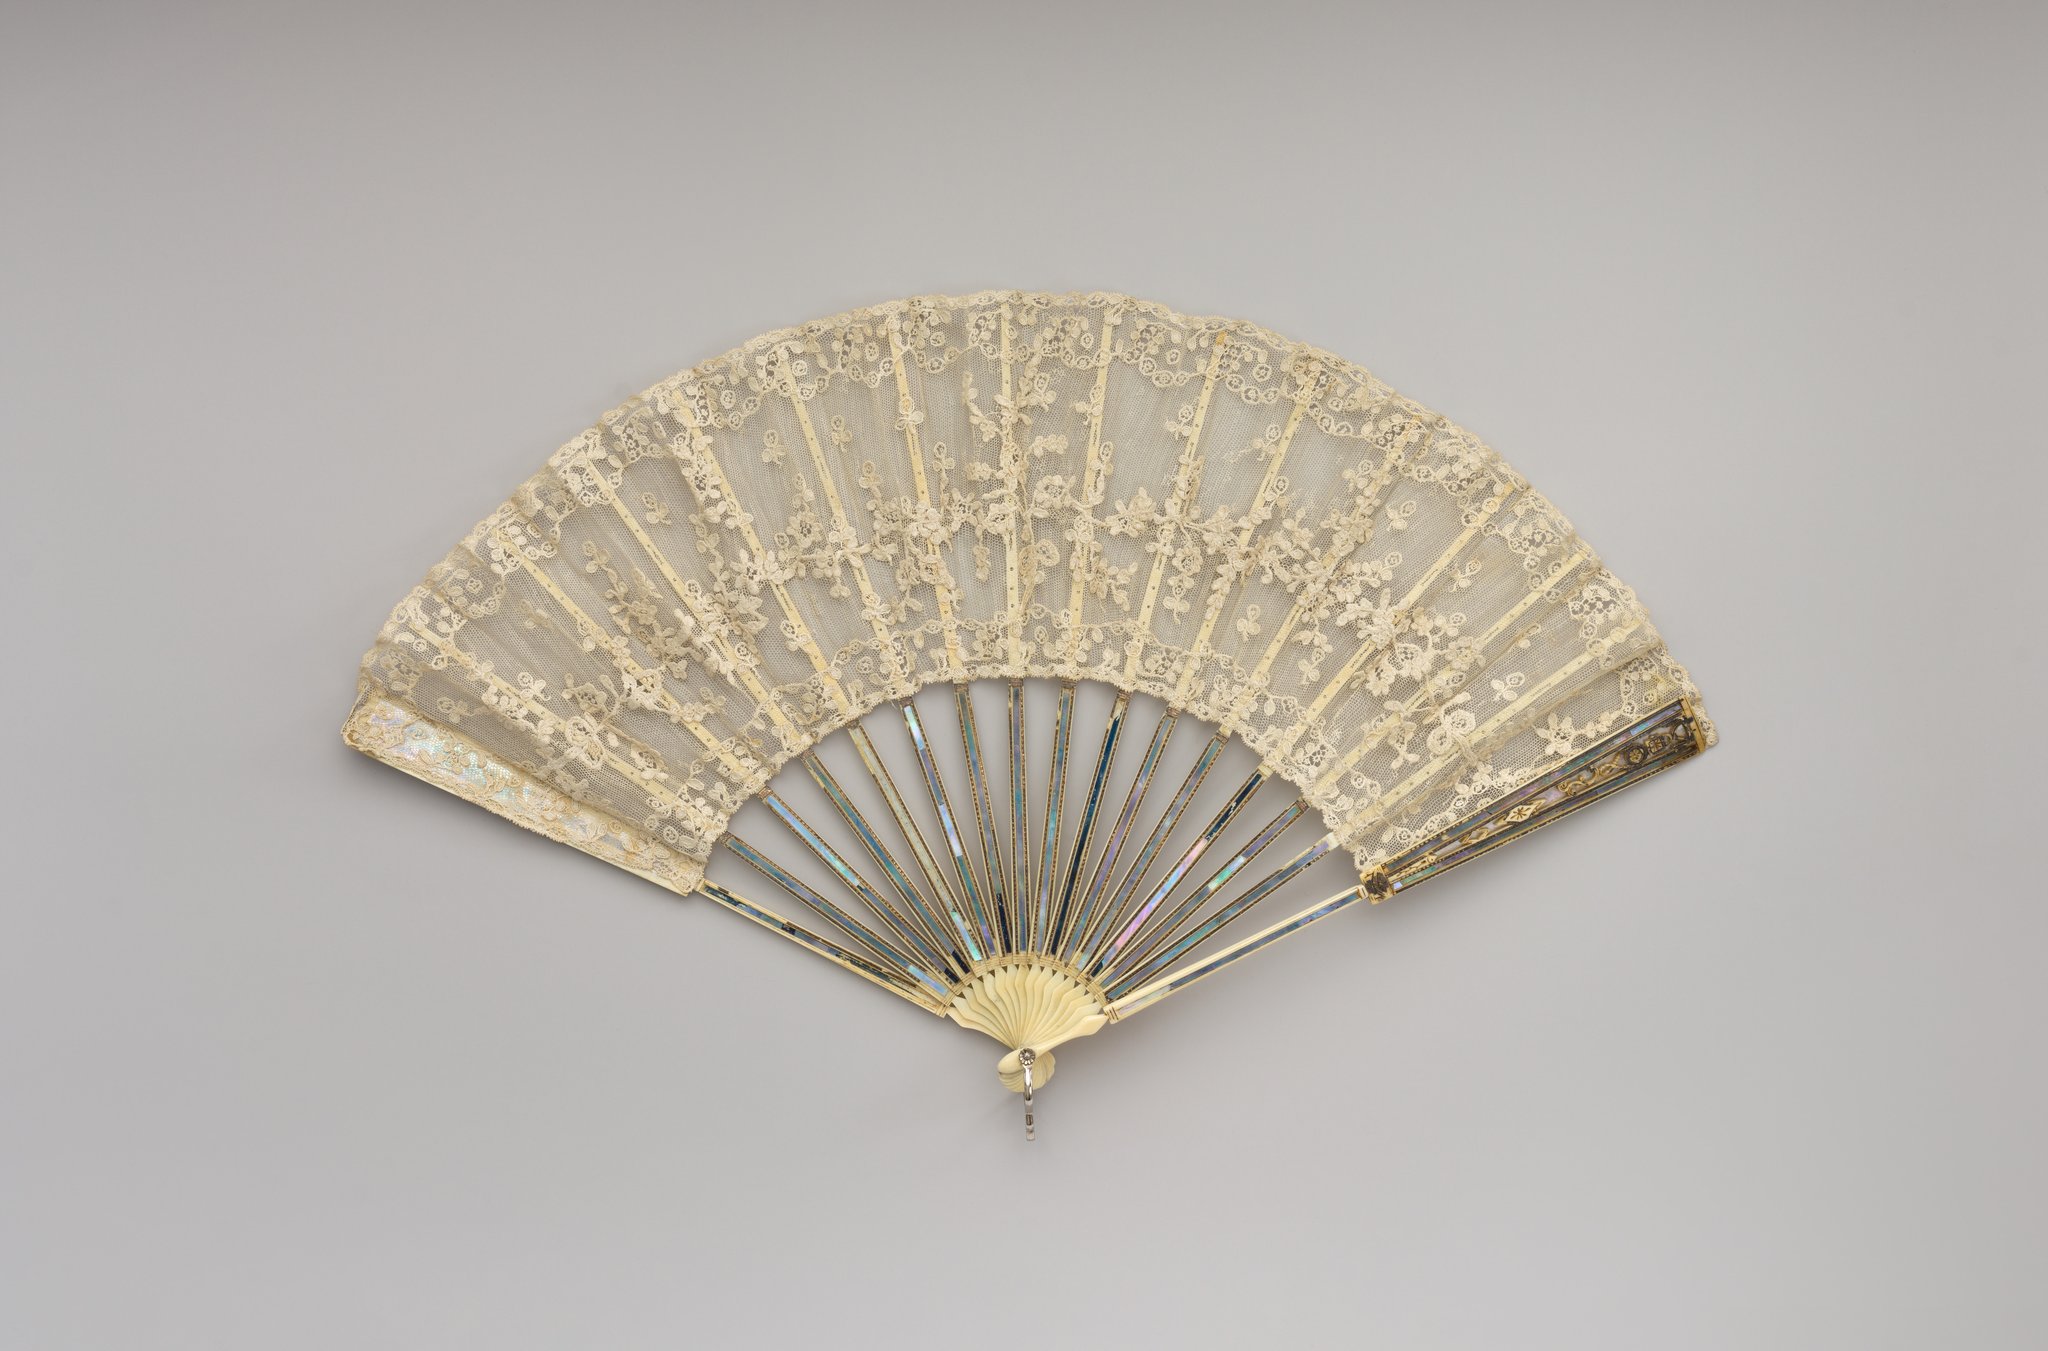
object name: fan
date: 1767-1800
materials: gilt, ivory, lace, mother of pearl